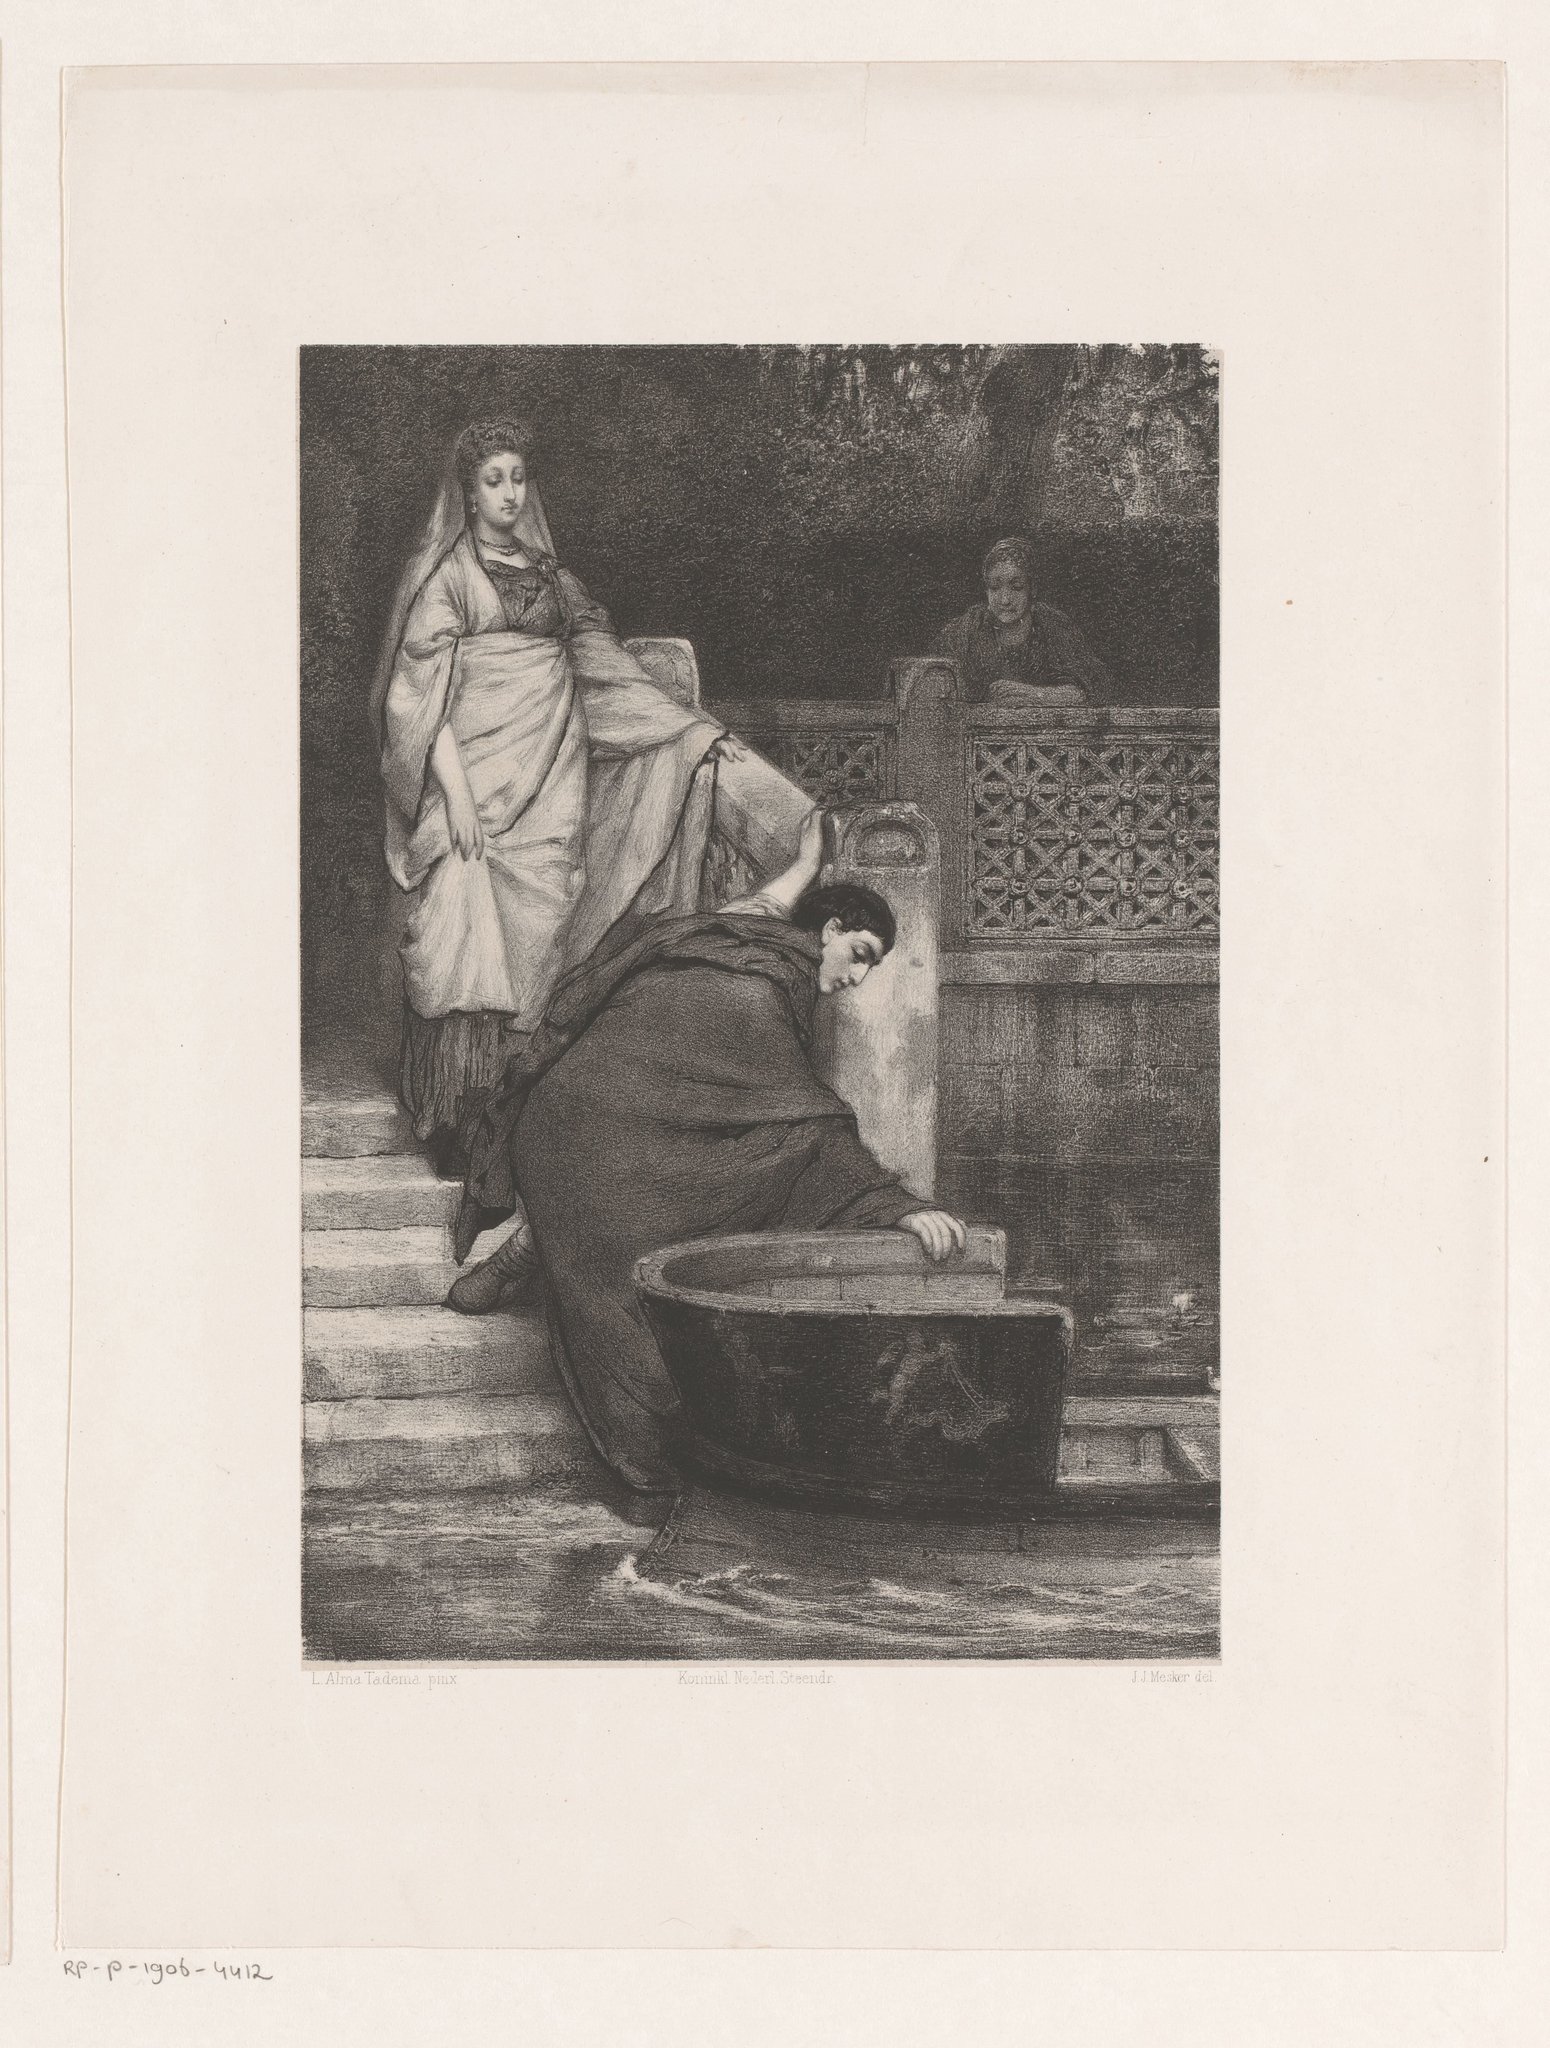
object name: print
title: Man helpt vrouw in boot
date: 1867-1874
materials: paper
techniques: lithograph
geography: the hague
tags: rowing-boat, canoe, etc. (+ getting in; mounting; embarkation), descending - aa - female human figure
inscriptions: collector's mark: Lugt 2228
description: De man trekt de boot naar de kant terwijl achter hem een vrouw de trap afdaalt. Naar het schilderij getiteld: Spelevaren.